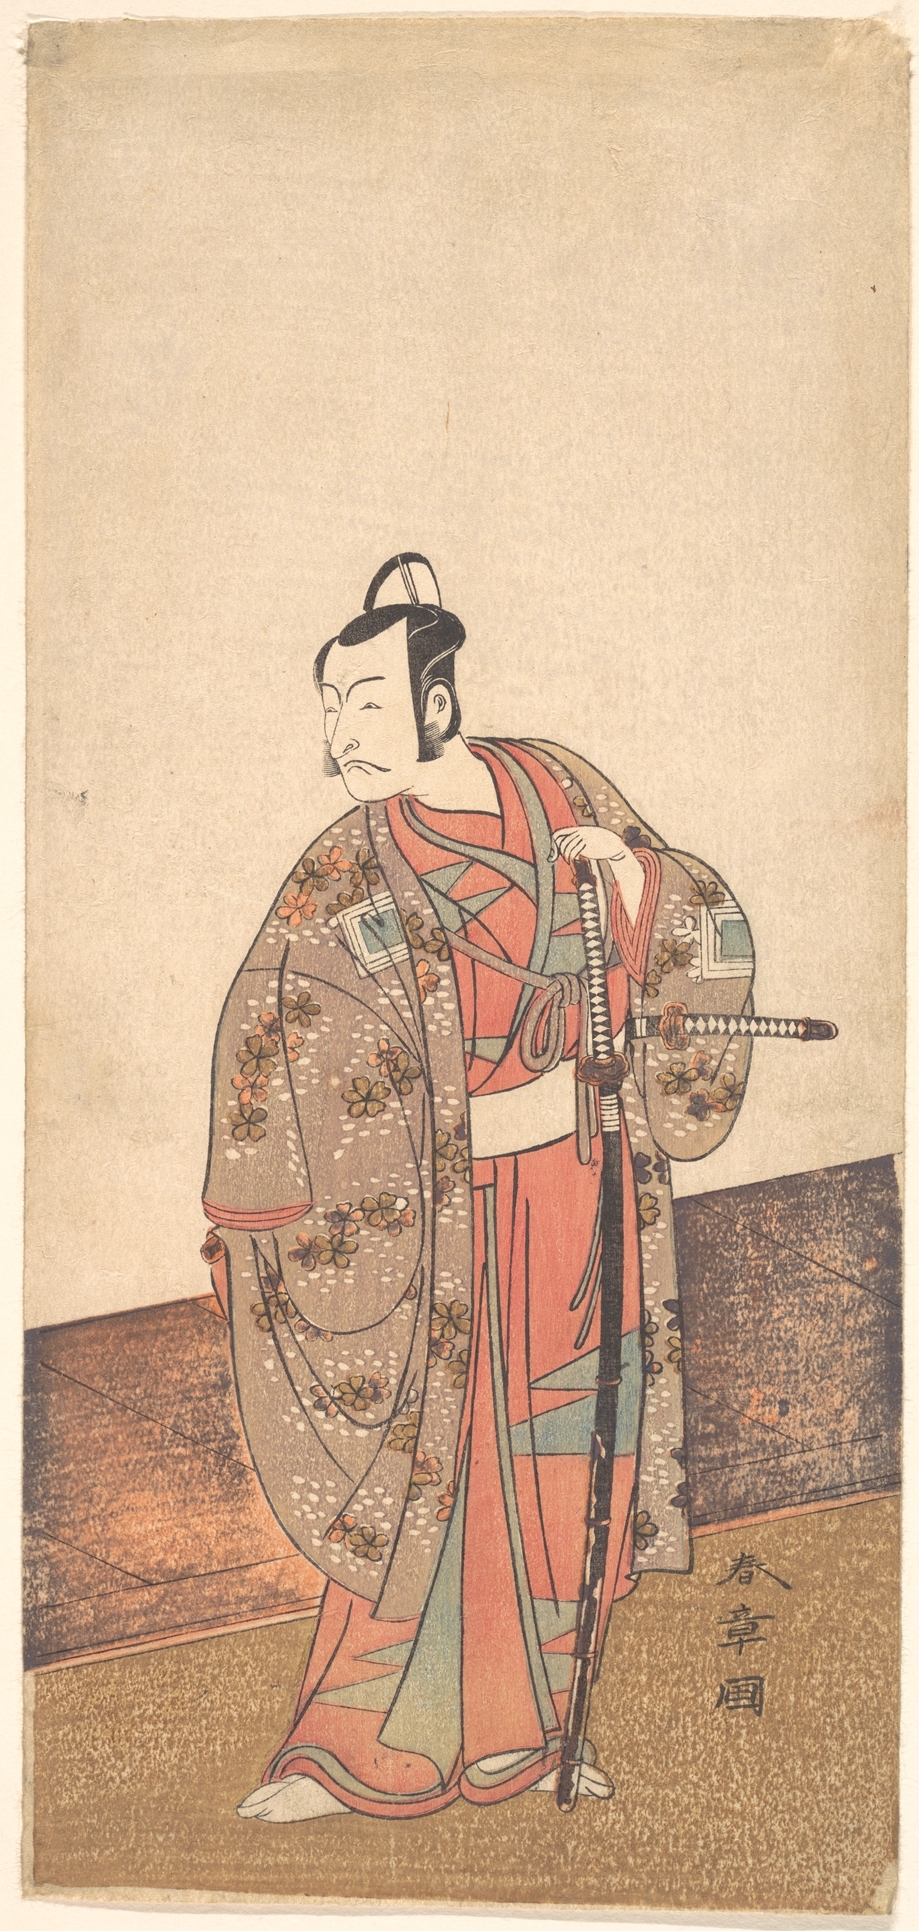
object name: woodblock print nishiki e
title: The Actor Ichikawa Danjuro V standing inside of a house and in front of an engawa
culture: japanese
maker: katsukawa shunshō 勝川春章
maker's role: artist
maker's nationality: japanese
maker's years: 1726-1792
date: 1772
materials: ink, paper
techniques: nishiki e, woodblock print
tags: swords,actors